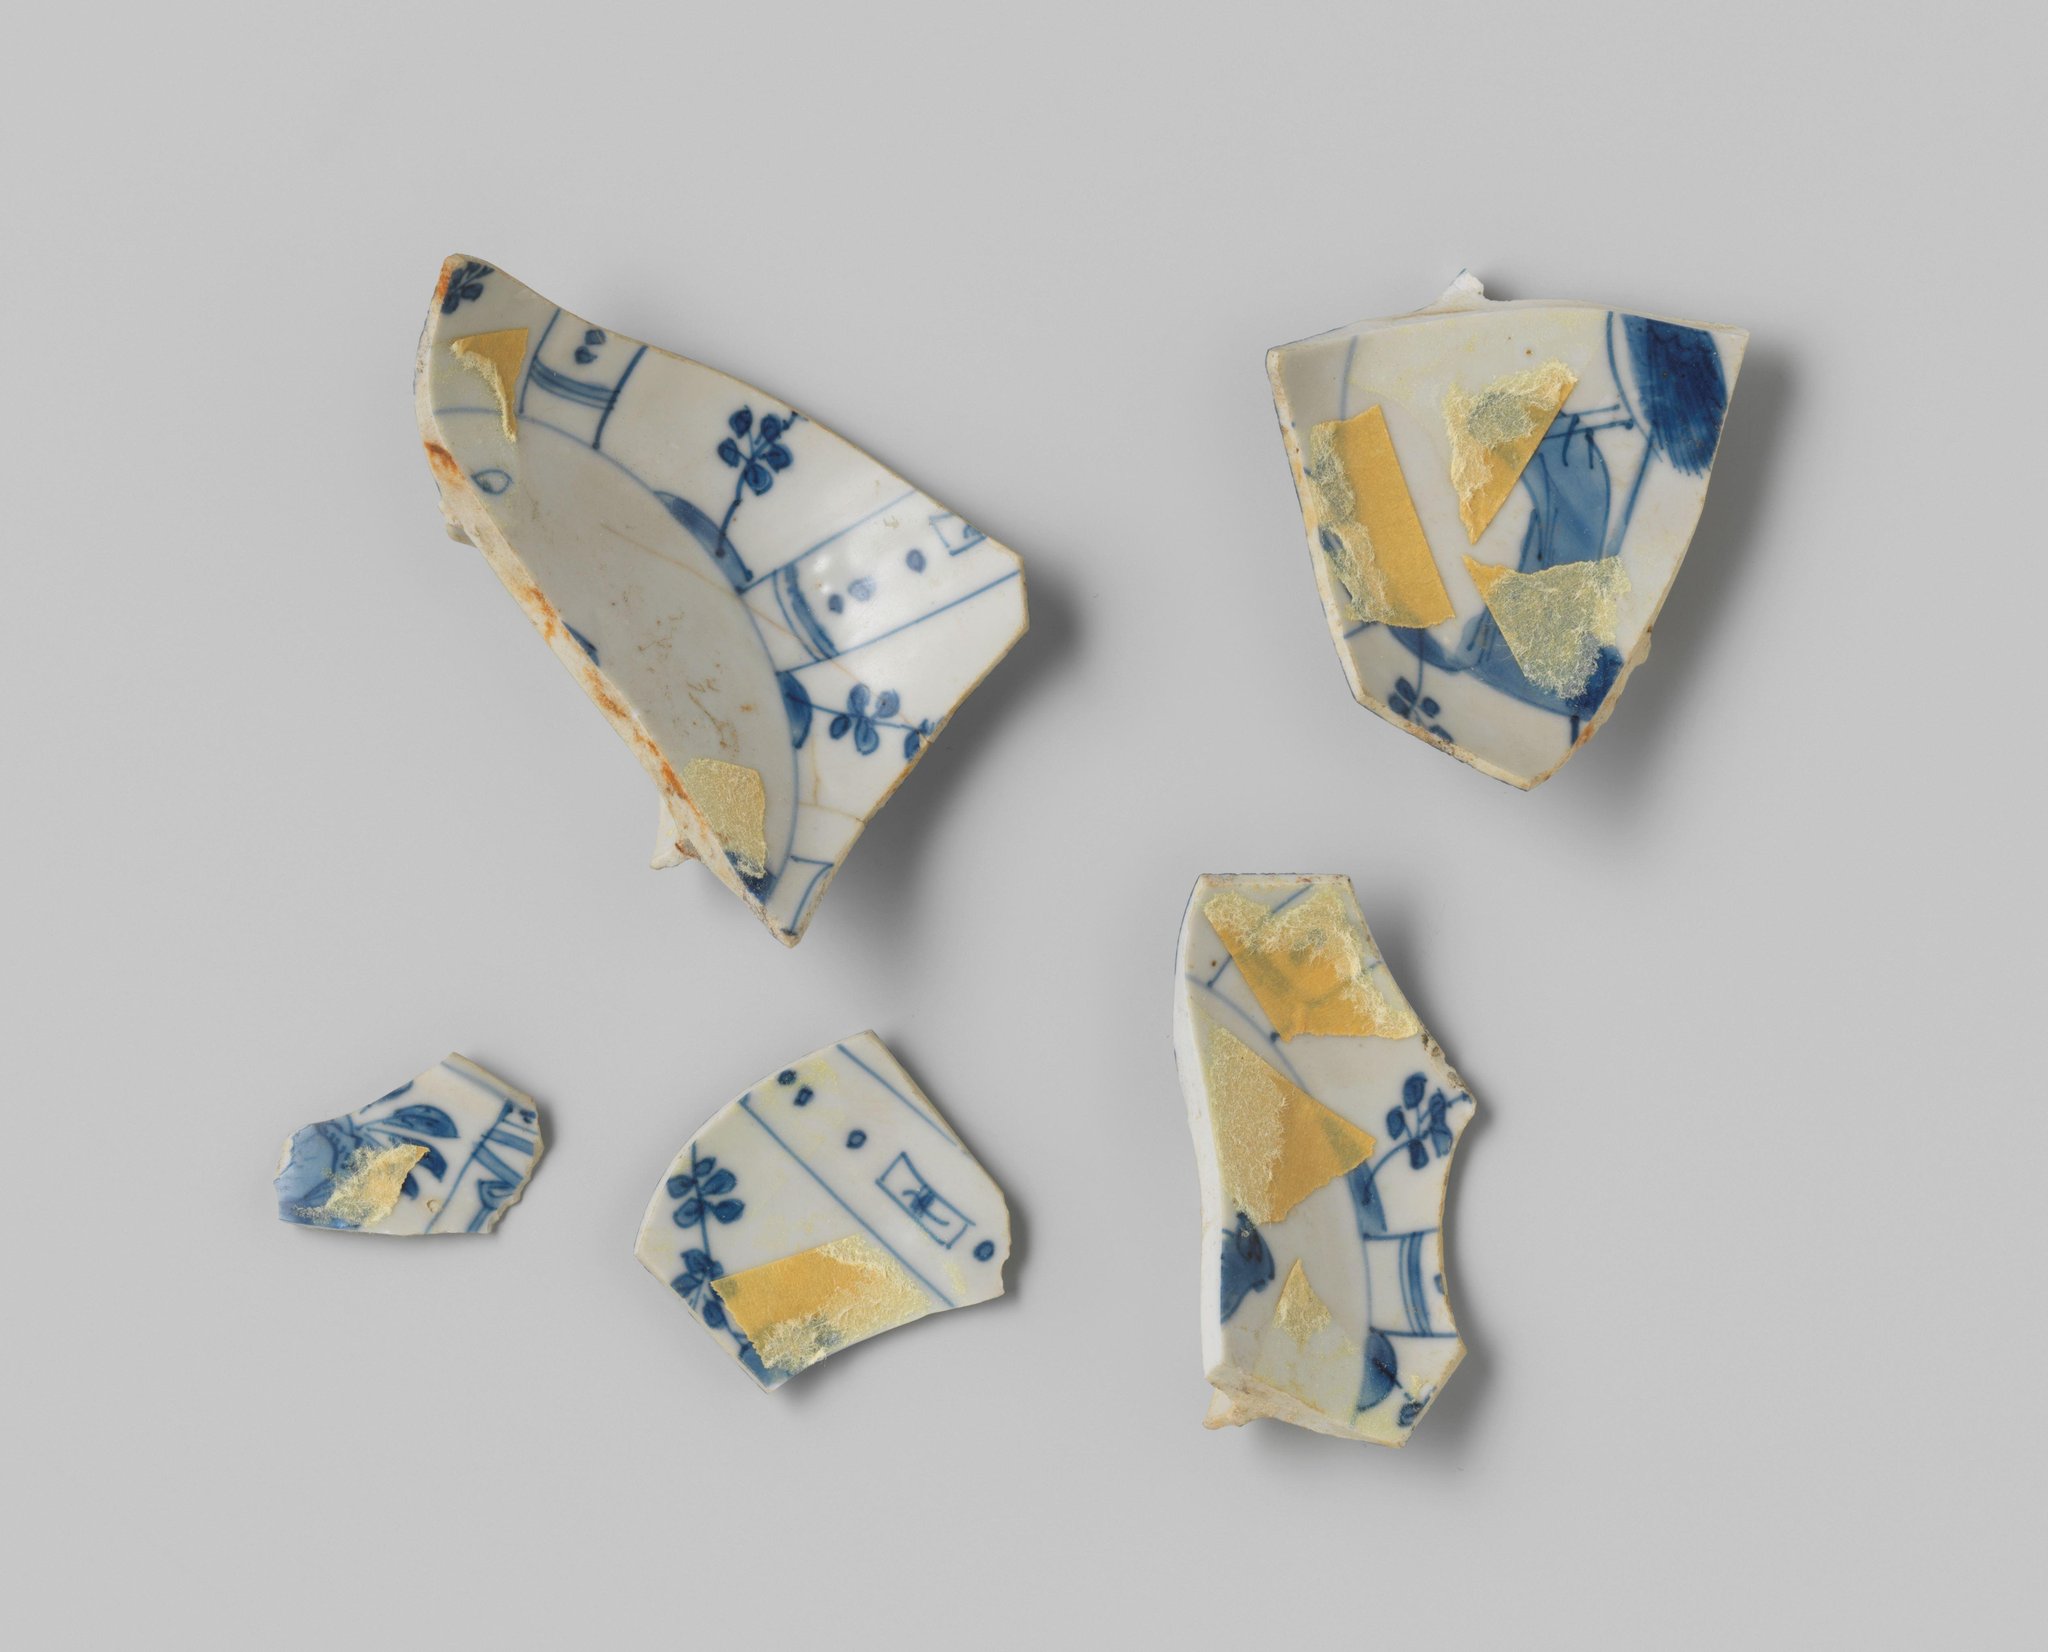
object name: sherd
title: Scherven van een kraaikop uit V.O.C.-schip de 'Witte Leeuw'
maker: Anonymous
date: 1613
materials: bone china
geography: jingdezhen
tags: verenigde oostindische compagnie, sint-helena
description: Scherven van een kraaikop uit V.O.C.-schip de 'Witte Leeuw', 40% aanwezig.